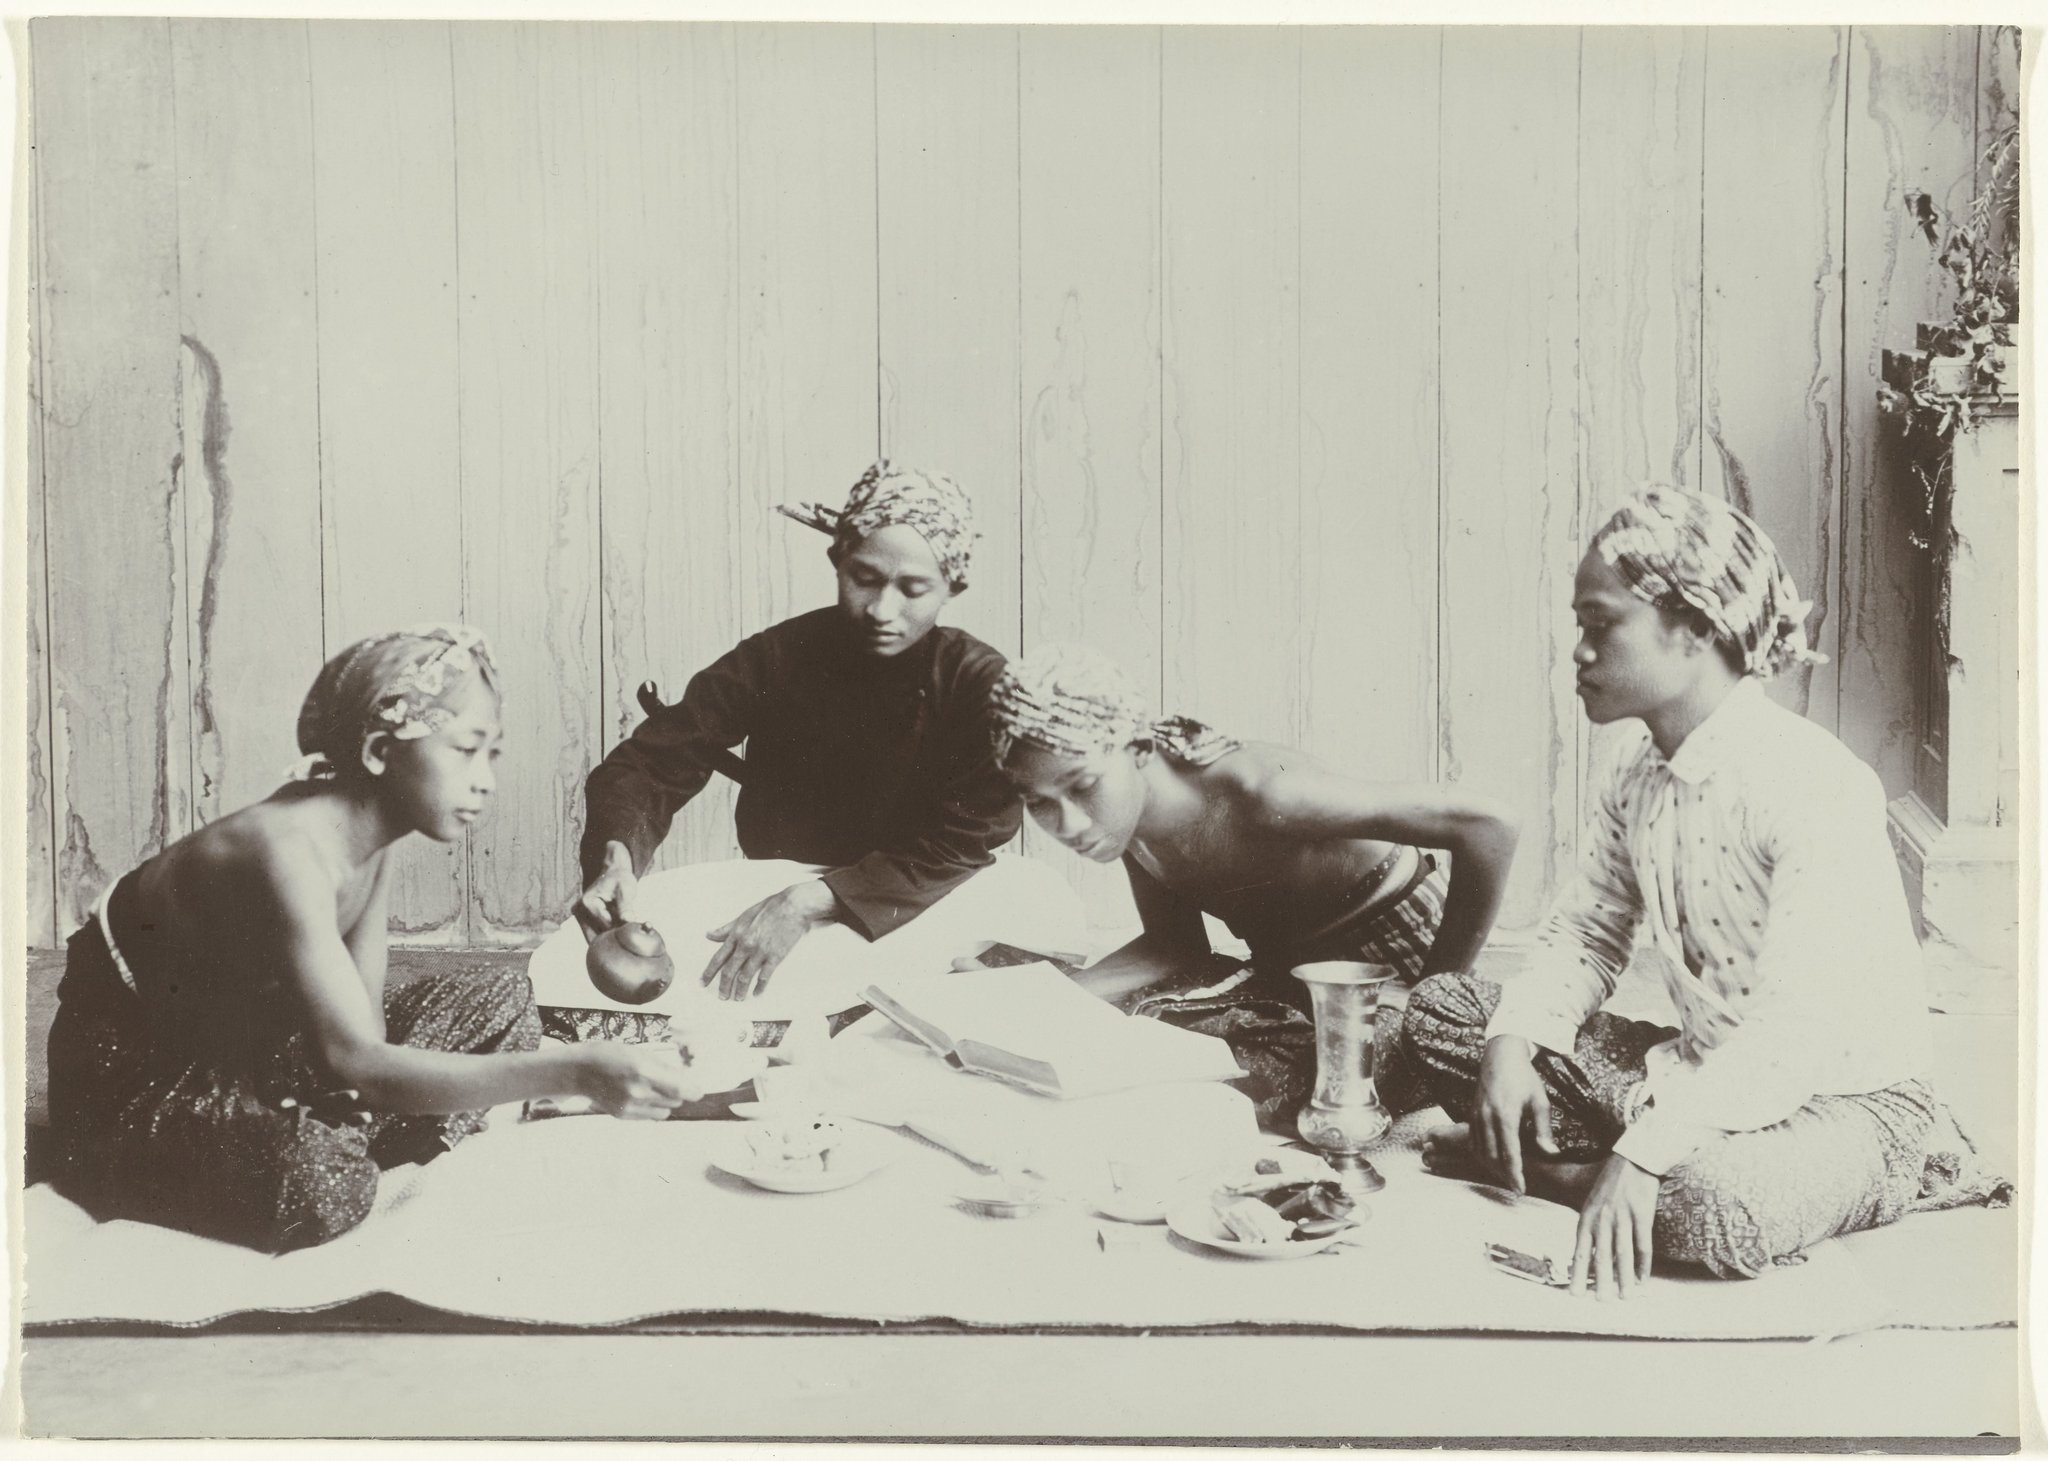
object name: photograph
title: Four Young Men Drinking Coffee or Tea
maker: kassian céphas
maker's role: fotograaf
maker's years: 1845-1912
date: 1867-1910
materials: cardboard, paper, photographic support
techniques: albumen print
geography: java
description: In addition to formal events at court, Céphas also photographed informal scenes from everyday life. These young men are placed in a studio setting and drink coffee or tea. Their postures and movements come across as very easy and natural and they may in fact be Céphas’ own sons or assistants.